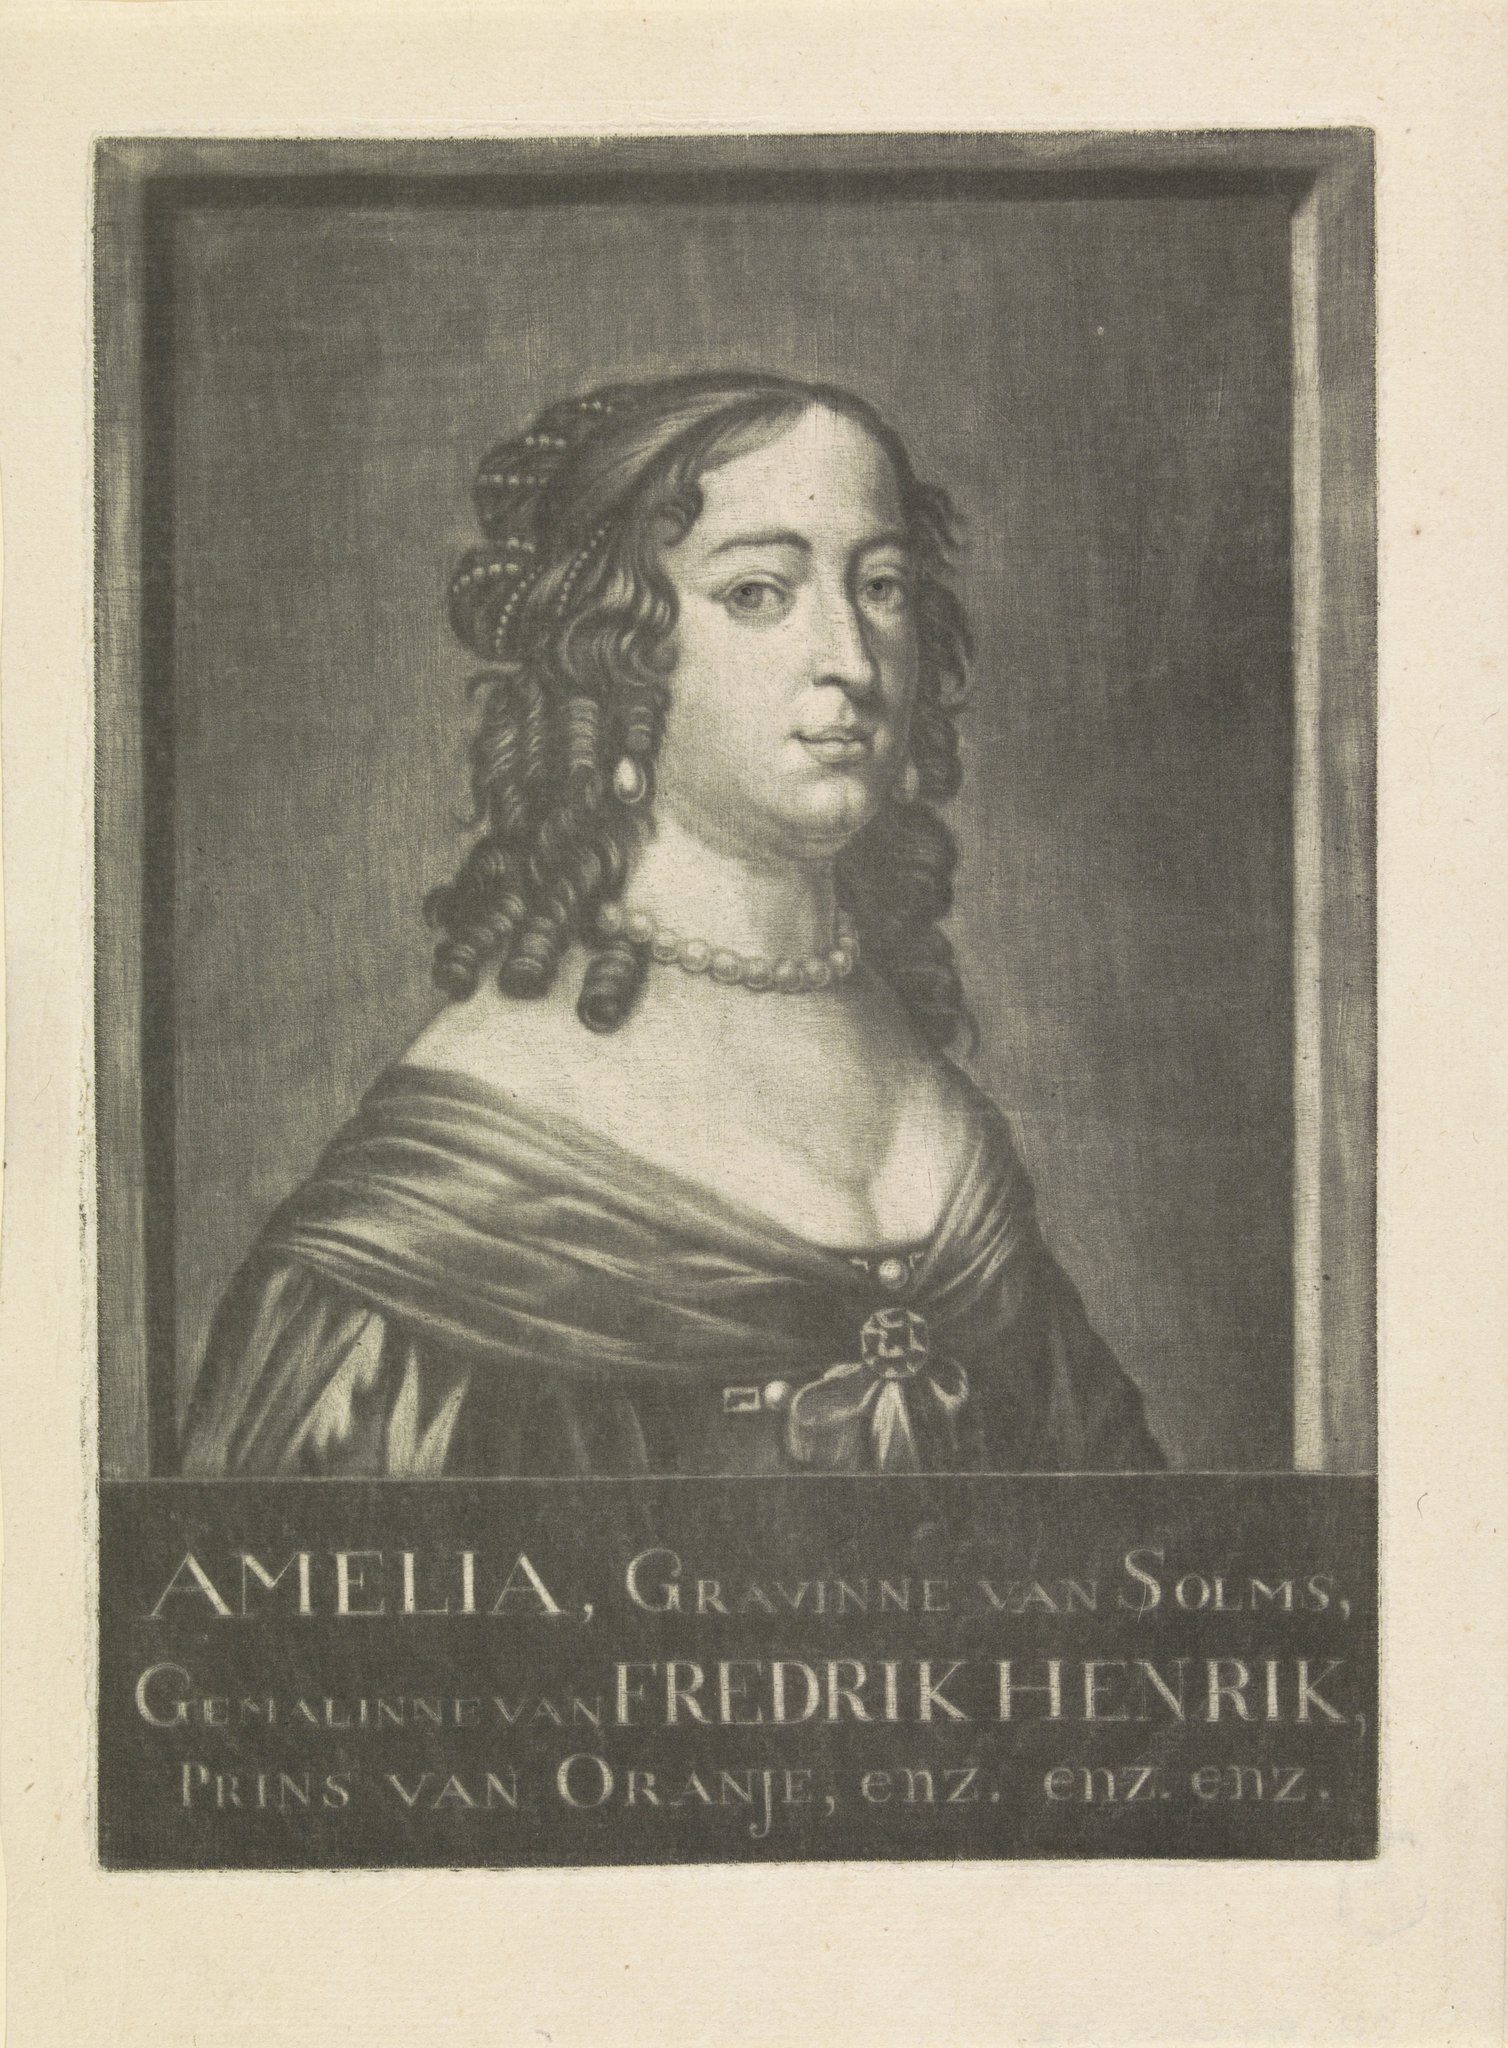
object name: book illustration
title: Portret van Amalia van Solms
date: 1770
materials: paper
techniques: mezzotint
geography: northern netherlands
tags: the hague, amalia of solms-braunfels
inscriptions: collector's mark: Lugt 963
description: De hier vermelde titel verwijst naar de hoogst verkregen titel van de geportretteerde, niet per se naar de titel die de geportretteerde op deze voorstelling draagt. Prent uit: Bosch, Johannes van den. De heeren stadhouderen van Vriesland, zedert den jare acht-hondert, volgens hoogst derzelver successie kortelyk beschreven. Leeuwarden: Abraham Ferwerda en Gerrit Tresling, 1770.